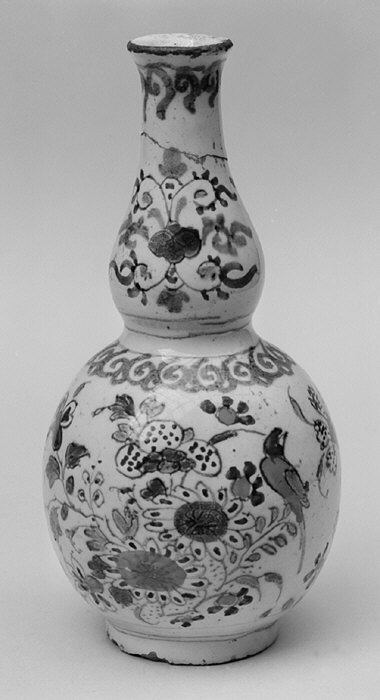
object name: bottle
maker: william cleffius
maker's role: maker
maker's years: 1650-1750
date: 1700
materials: earthenware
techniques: glazing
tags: birds,flowers